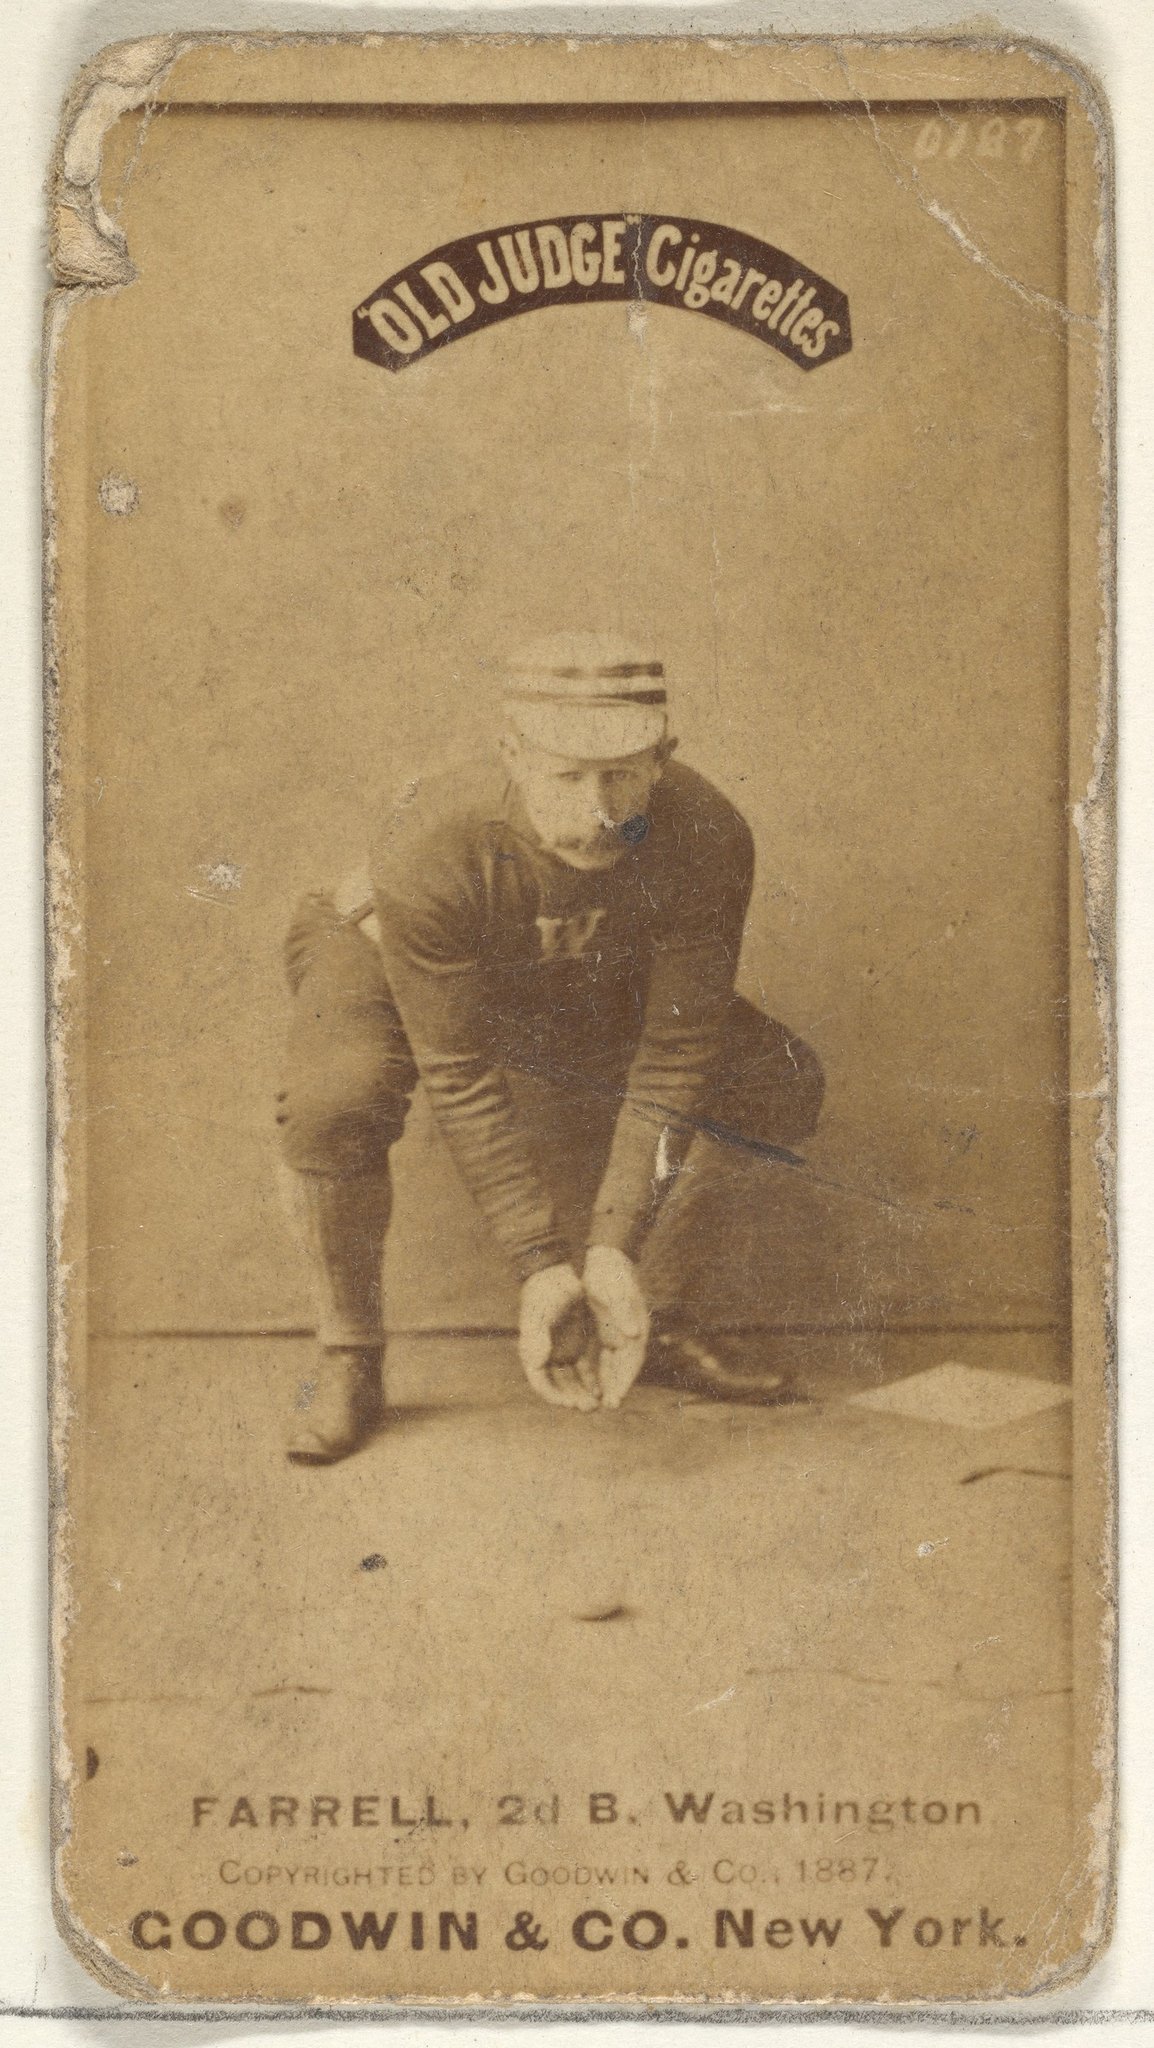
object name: baseball card, photograph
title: John A. "Jack" Farrell, 2nd Base, Washington Nationals, from the Old Judge series (N172) for Old Judge Cigarettes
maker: goodwin & company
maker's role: publisher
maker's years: 1850-1950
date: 1887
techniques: albumen silver print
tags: men,portraits,baseball,athletes